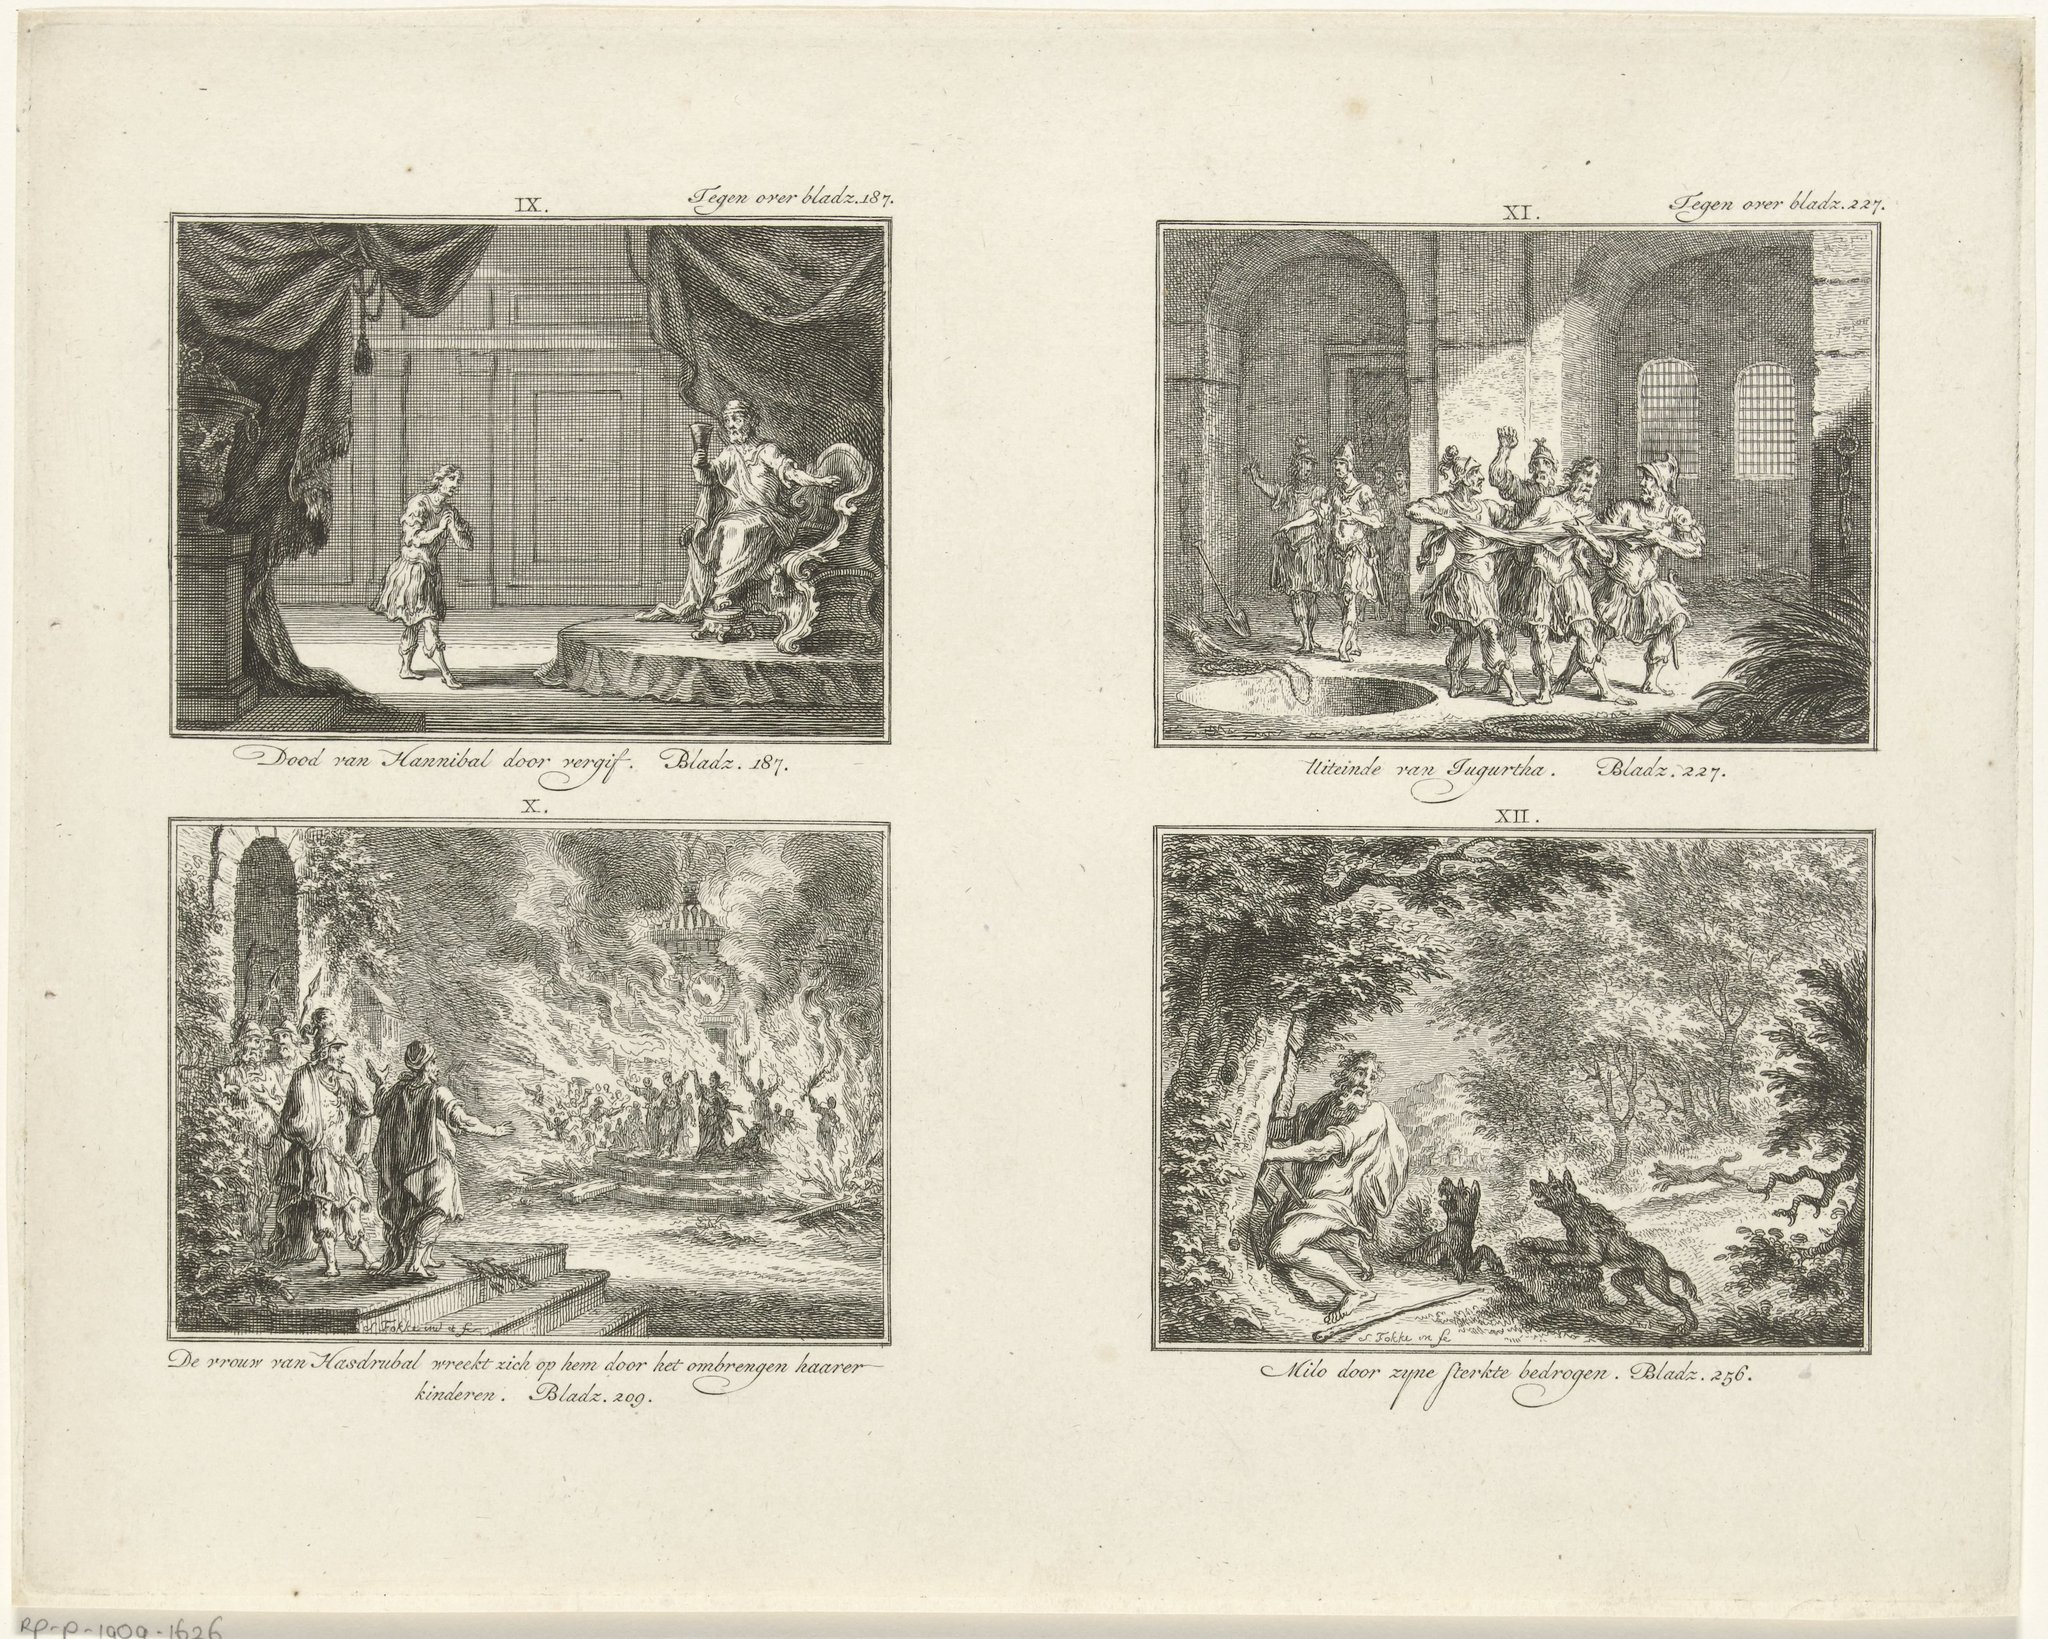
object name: print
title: Vier voorstellingen uit de klassieke geschiedenis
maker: simon fokke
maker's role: draughtsman, print maker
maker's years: 1712-1784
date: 1722-1784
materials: paper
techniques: etching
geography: amsterdam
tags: (story of) hannibal, male persons from classical history (milo), male persons from classical history (jugurtha), (story of) the wife of hasdrubal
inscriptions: collector's mark: Lugt 2228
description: Vier voorstellingen uit de klassieke geschiedenis van één plaat, genummerd van IX tot en met XII en alle voorzien van een onderschrift. Linksboven: Hannibal wordt vergiftigd. Linksonder: De vrouw van Hasdrubal brengt haar eigen kinderen om. Rechtsboven: Ondergang van Jugurtha. Rechtsonder: Milo door zijn eigen kracht bedrogen. Voorstellingen IX en X rechtsboven gemerkt: Tegen over bladz. 187. Voorstellingen XI en XII rechtsboven gemerkt: Tegen over bladz. 227.